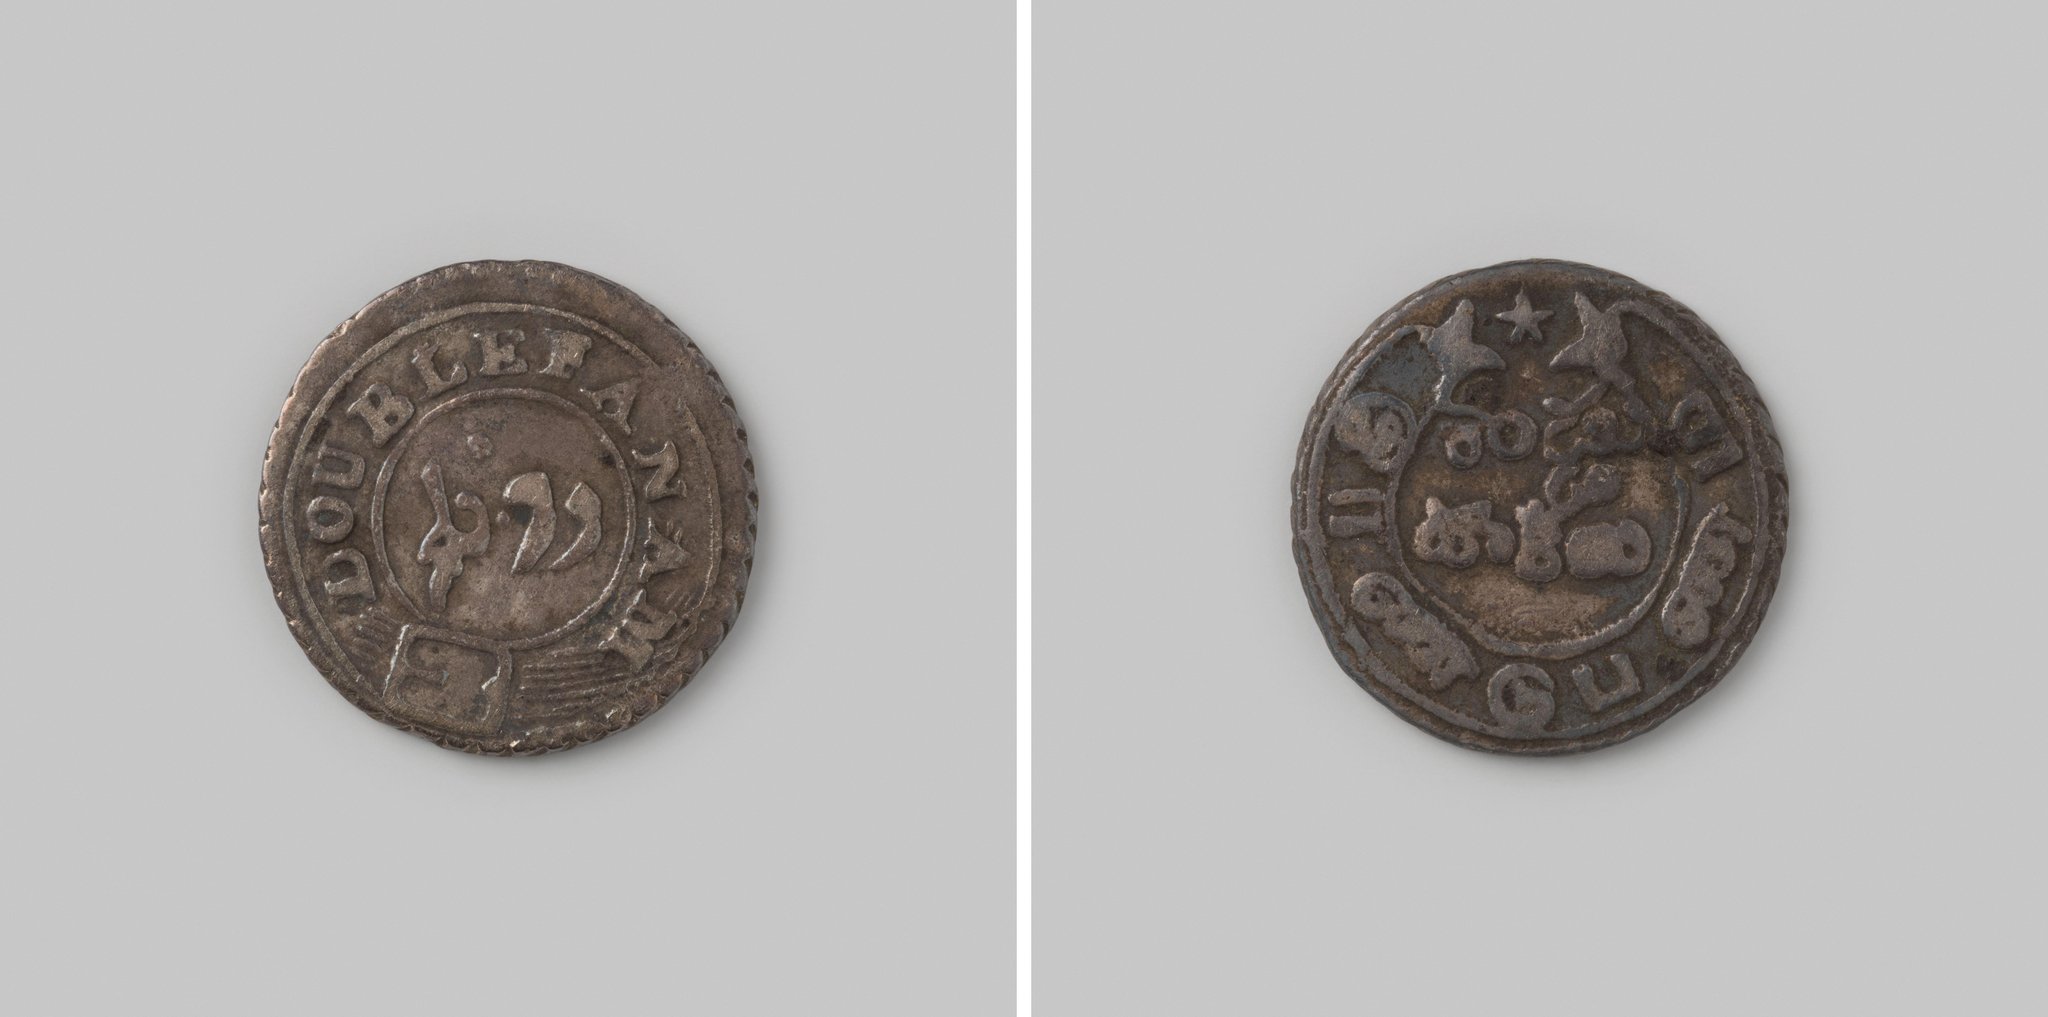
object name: coin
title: 2 fanams voor Madras in India van de Engelse Oostindische Compagnie (EIC), (1808)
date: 1808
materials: silver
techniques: striking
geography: chennai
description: Zilveren munt. Voorzijde: binnen cirkel, gevormd door ceintuur met gesp, waarde-aanduiding in het Engels: double fanam, op een regel waarde-aanduiding in Arabische lettertekens. Keerzijde: binnen cirkel, gevormd door lint, waarop waarde-aanduiding in het Tamil, in twee regels waarde-aanduiding in het Telugu. Bovenaan, tussen uiteinden van het lint, een ster. Kabelrand.